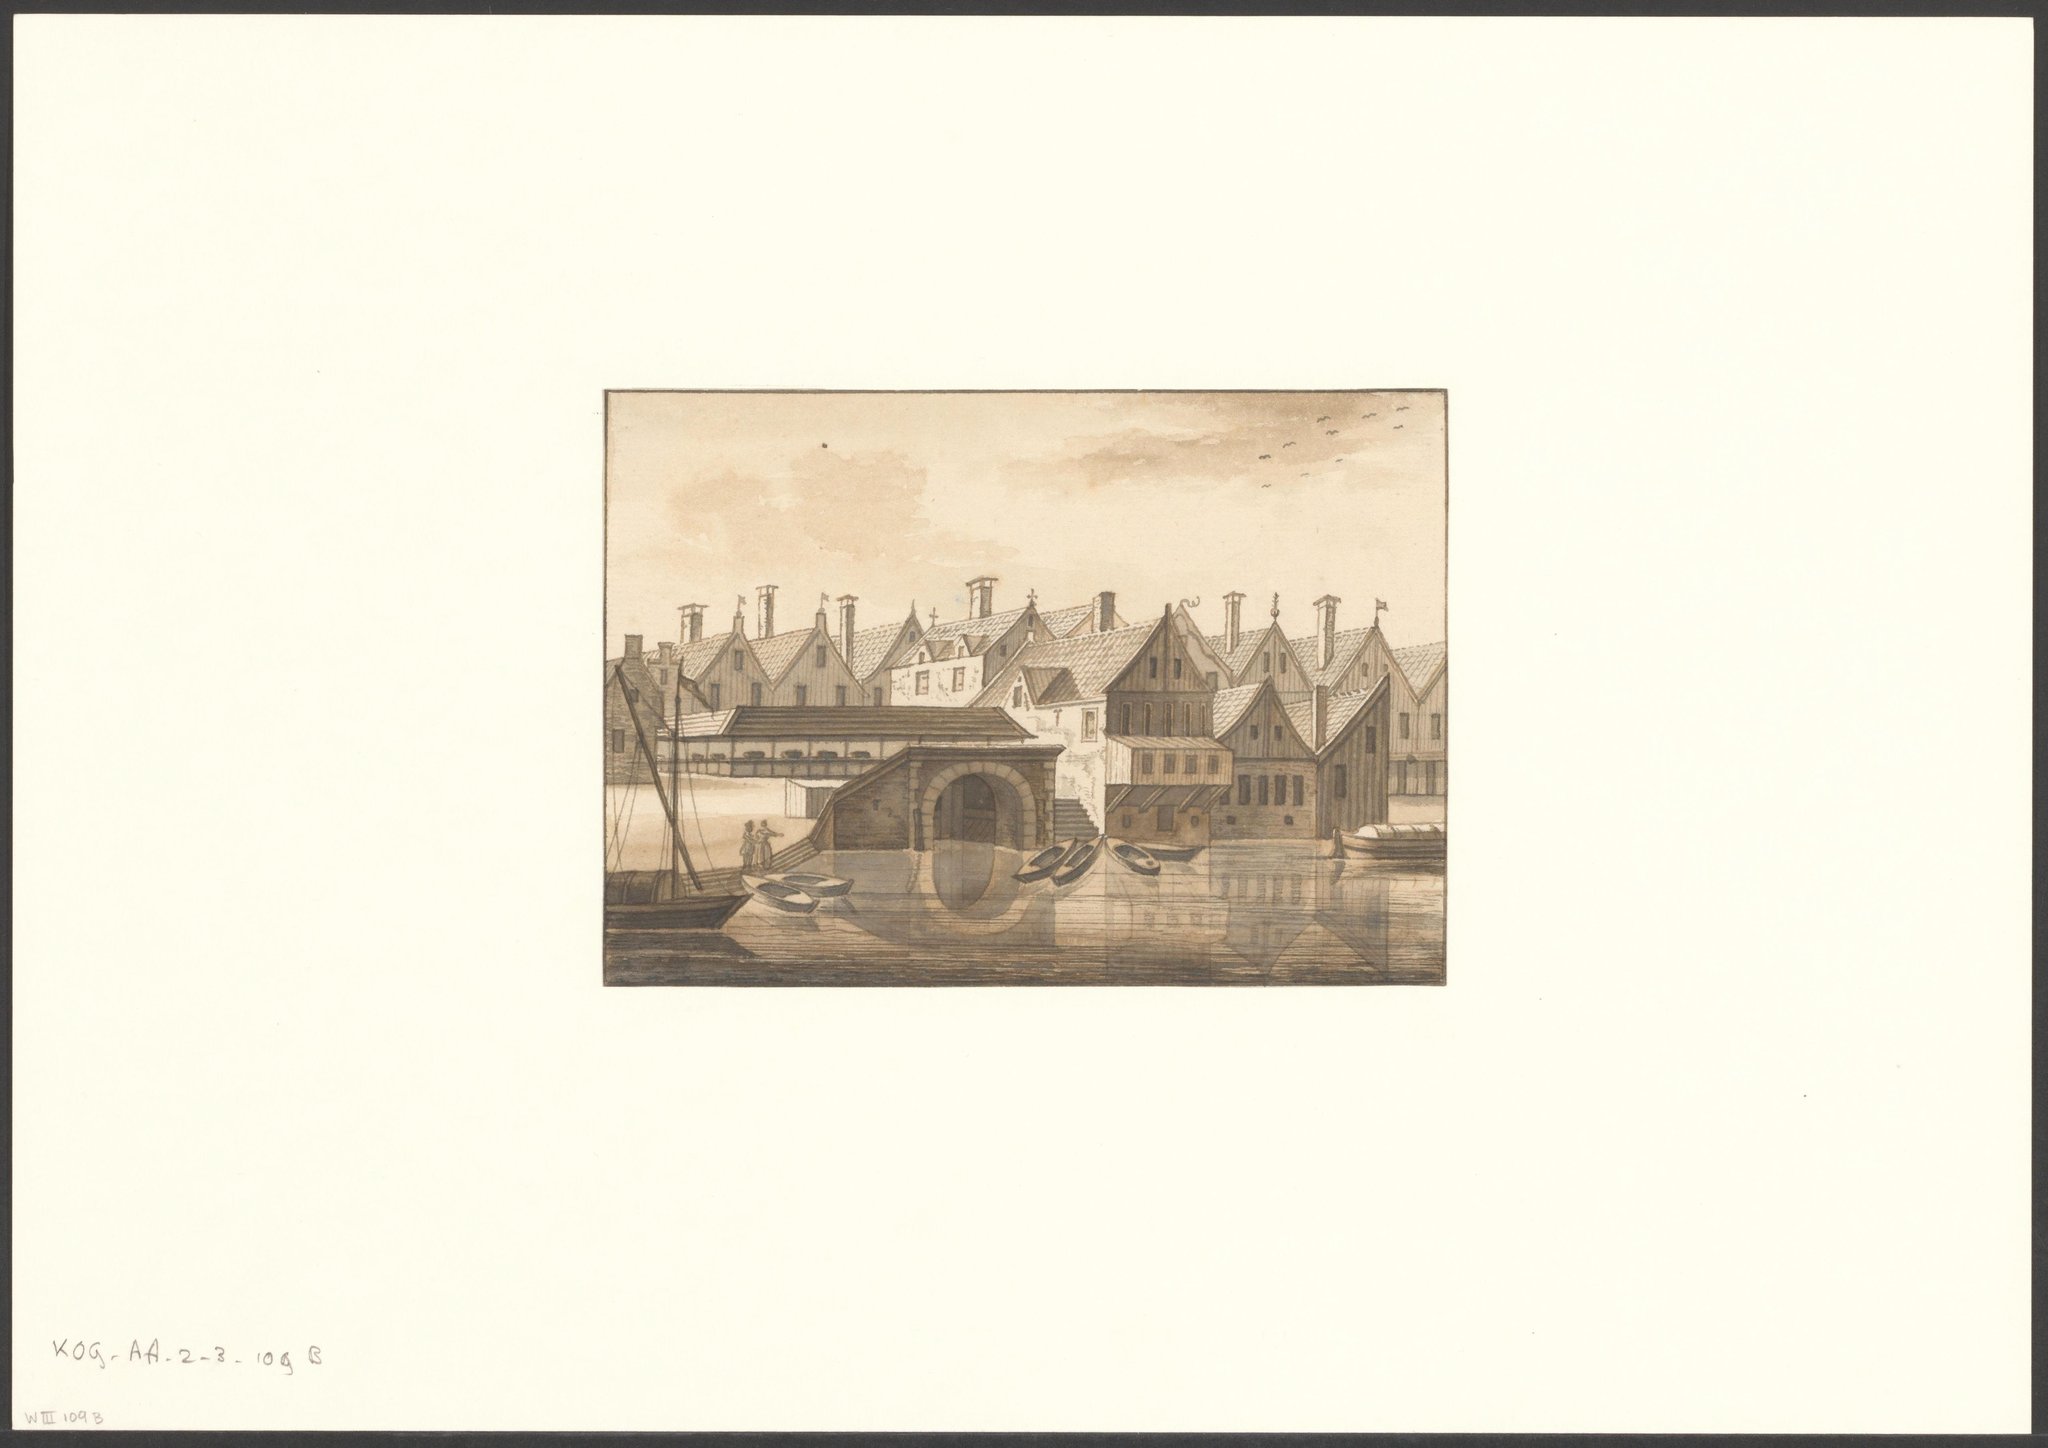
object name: drawing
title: Gezicht op de vismarkt bij de Dam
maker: antonina houbraken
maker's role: draughtsman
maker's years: 1696-1736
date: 1706-1736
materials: ink, paper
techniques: brush, pen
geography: amsterdam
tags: city-view in general; 'veduta', market, village square, place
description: Tekening binnen de Atlas Van Eck ingedeeld op wijknummer 3.